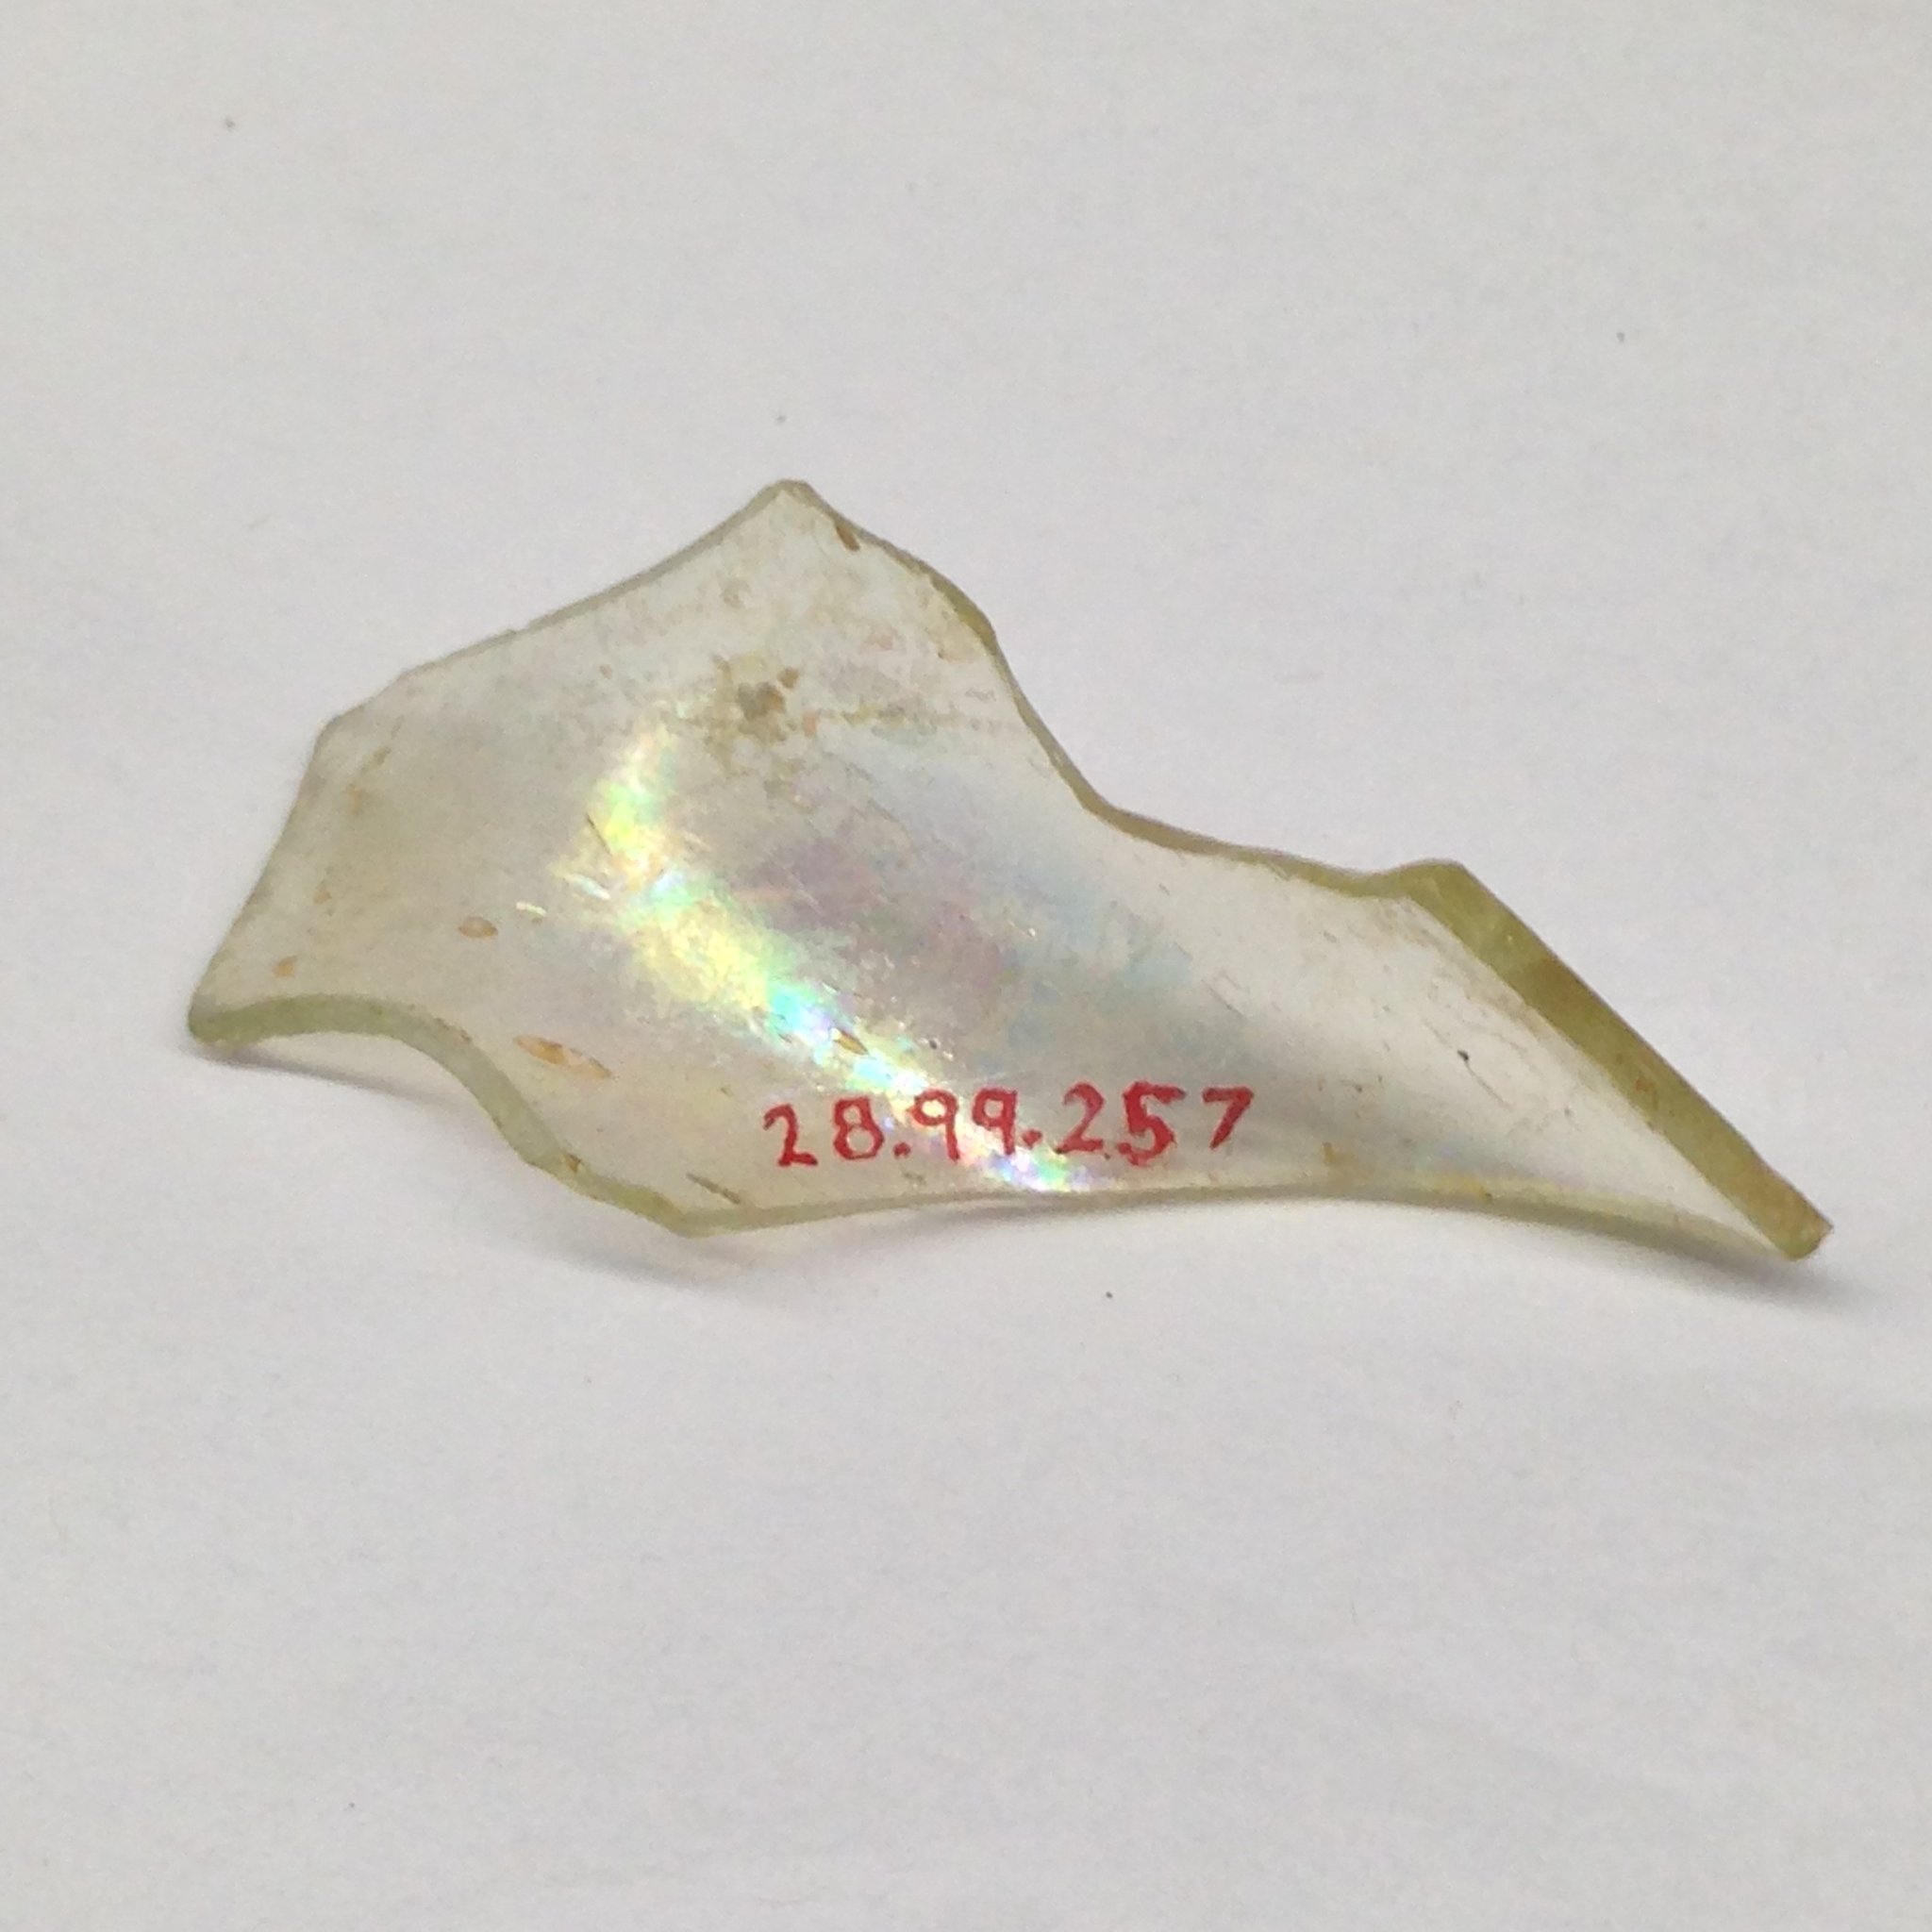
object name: fragment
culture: european or middle eastern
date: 1150-1250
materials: ceramic, glass